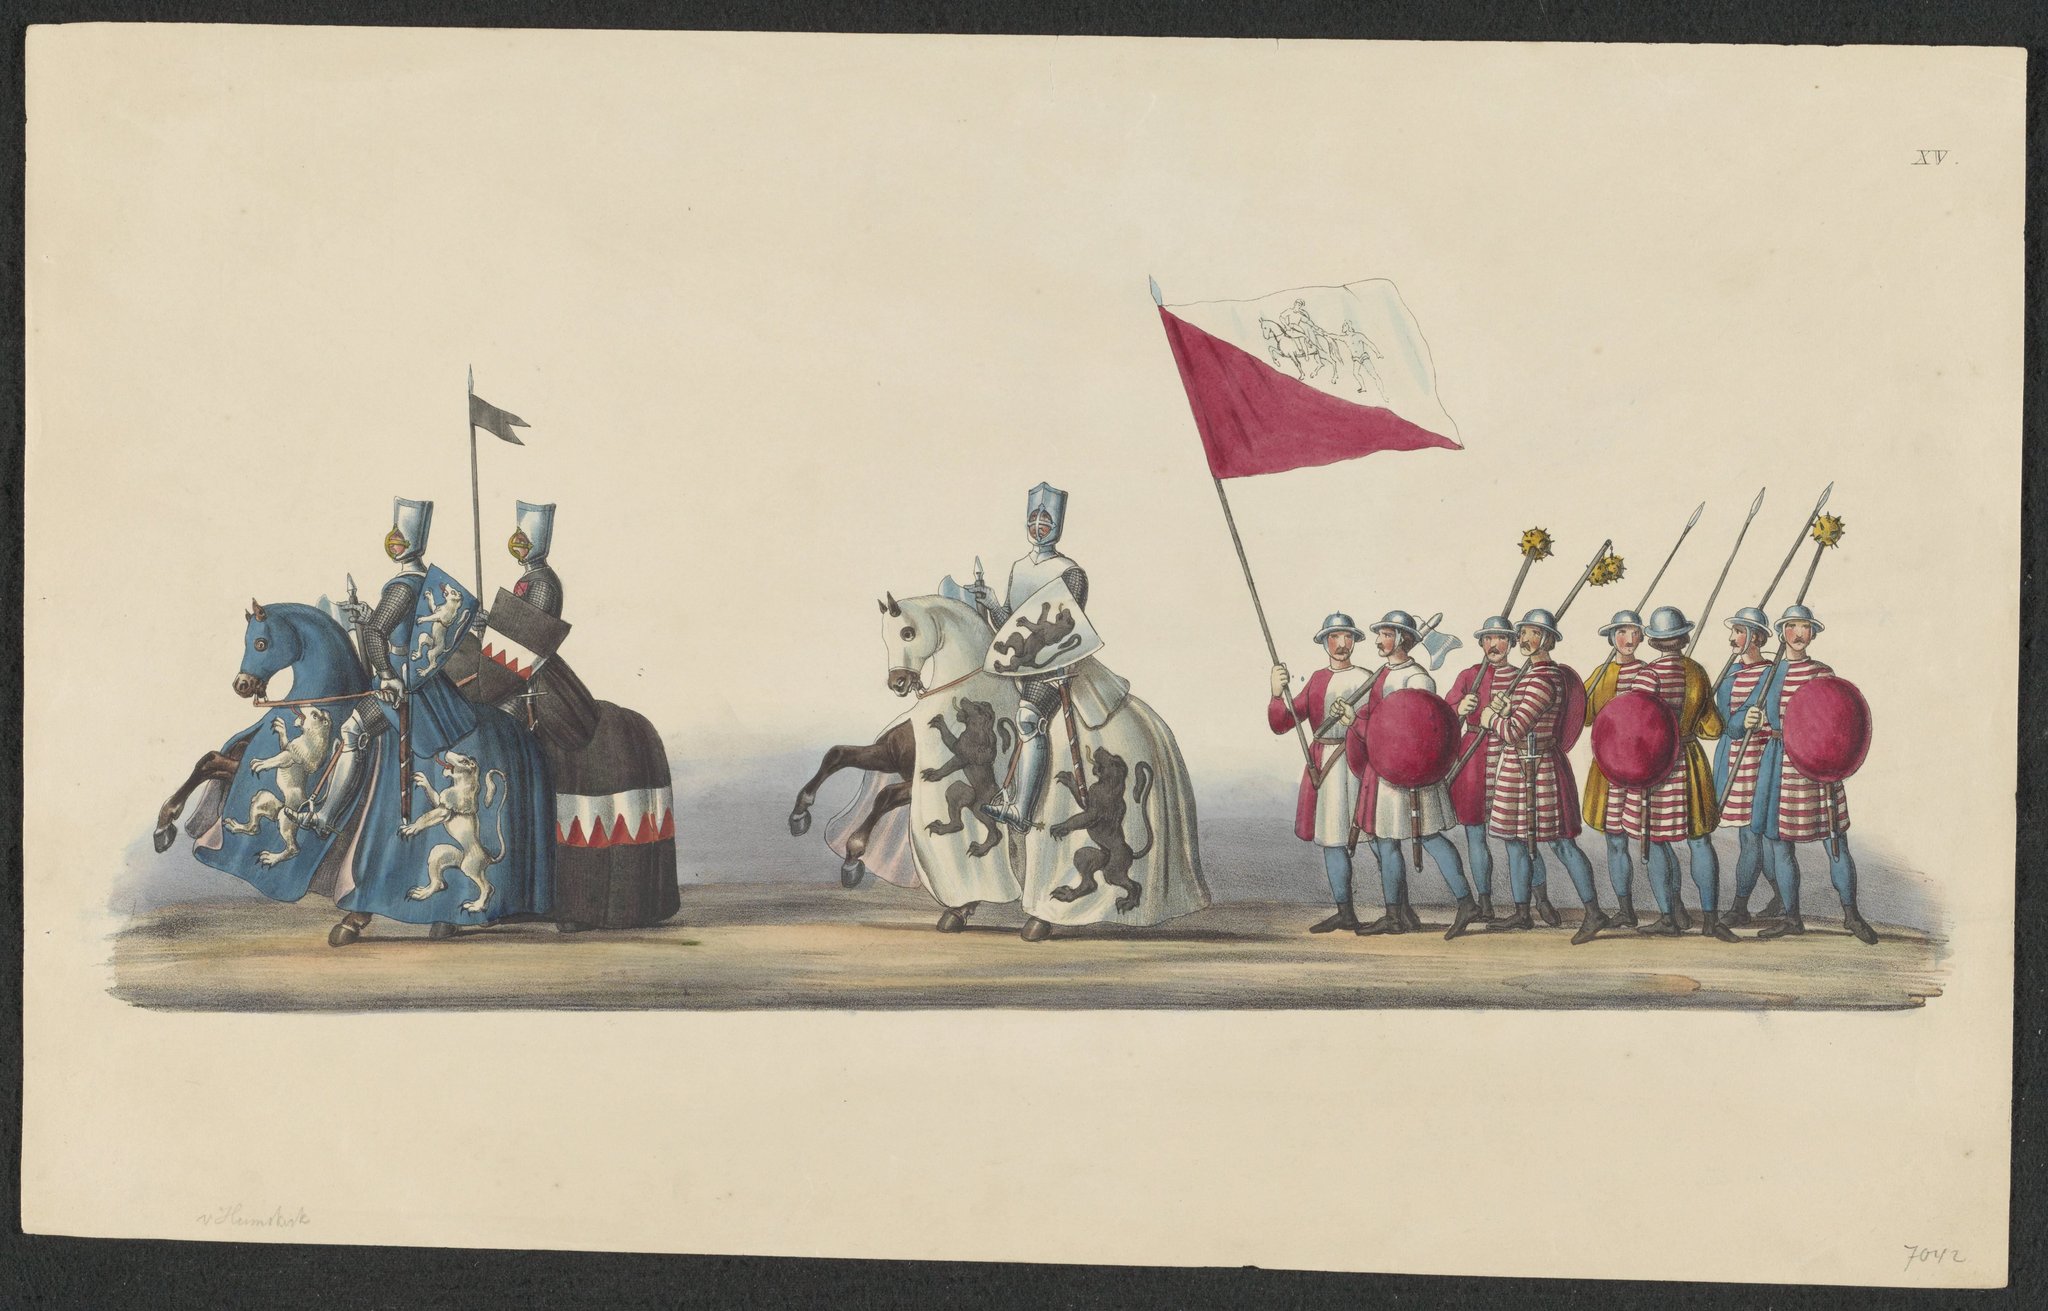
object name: print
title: Gekostumeerde optocht van 1841: ridders (blad XV)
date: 1841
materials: paper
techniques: hand coloring, lithograph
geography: netherlands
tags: earl, students' pageant, costumes used in pageants, utrecht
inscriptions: collector's mark: Lugt 2228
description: Drie ridders in wapenrusting te paard, gevolgd door een groep voetsoldaten met het wapen van Utrecht. Blad genummerd XV in de serie van achttien platen van de historische gekostumeerde optocht voorstellende de ontvangst van graaf Willem II van Holland in Utrecht in 1249. De optocht gehouden door de studenten van de Universiteit van Utrecht op 2 juni 1841 ter gelegenheid van de viering van het vijfentwintigjarige herstel van de Hogeschool.